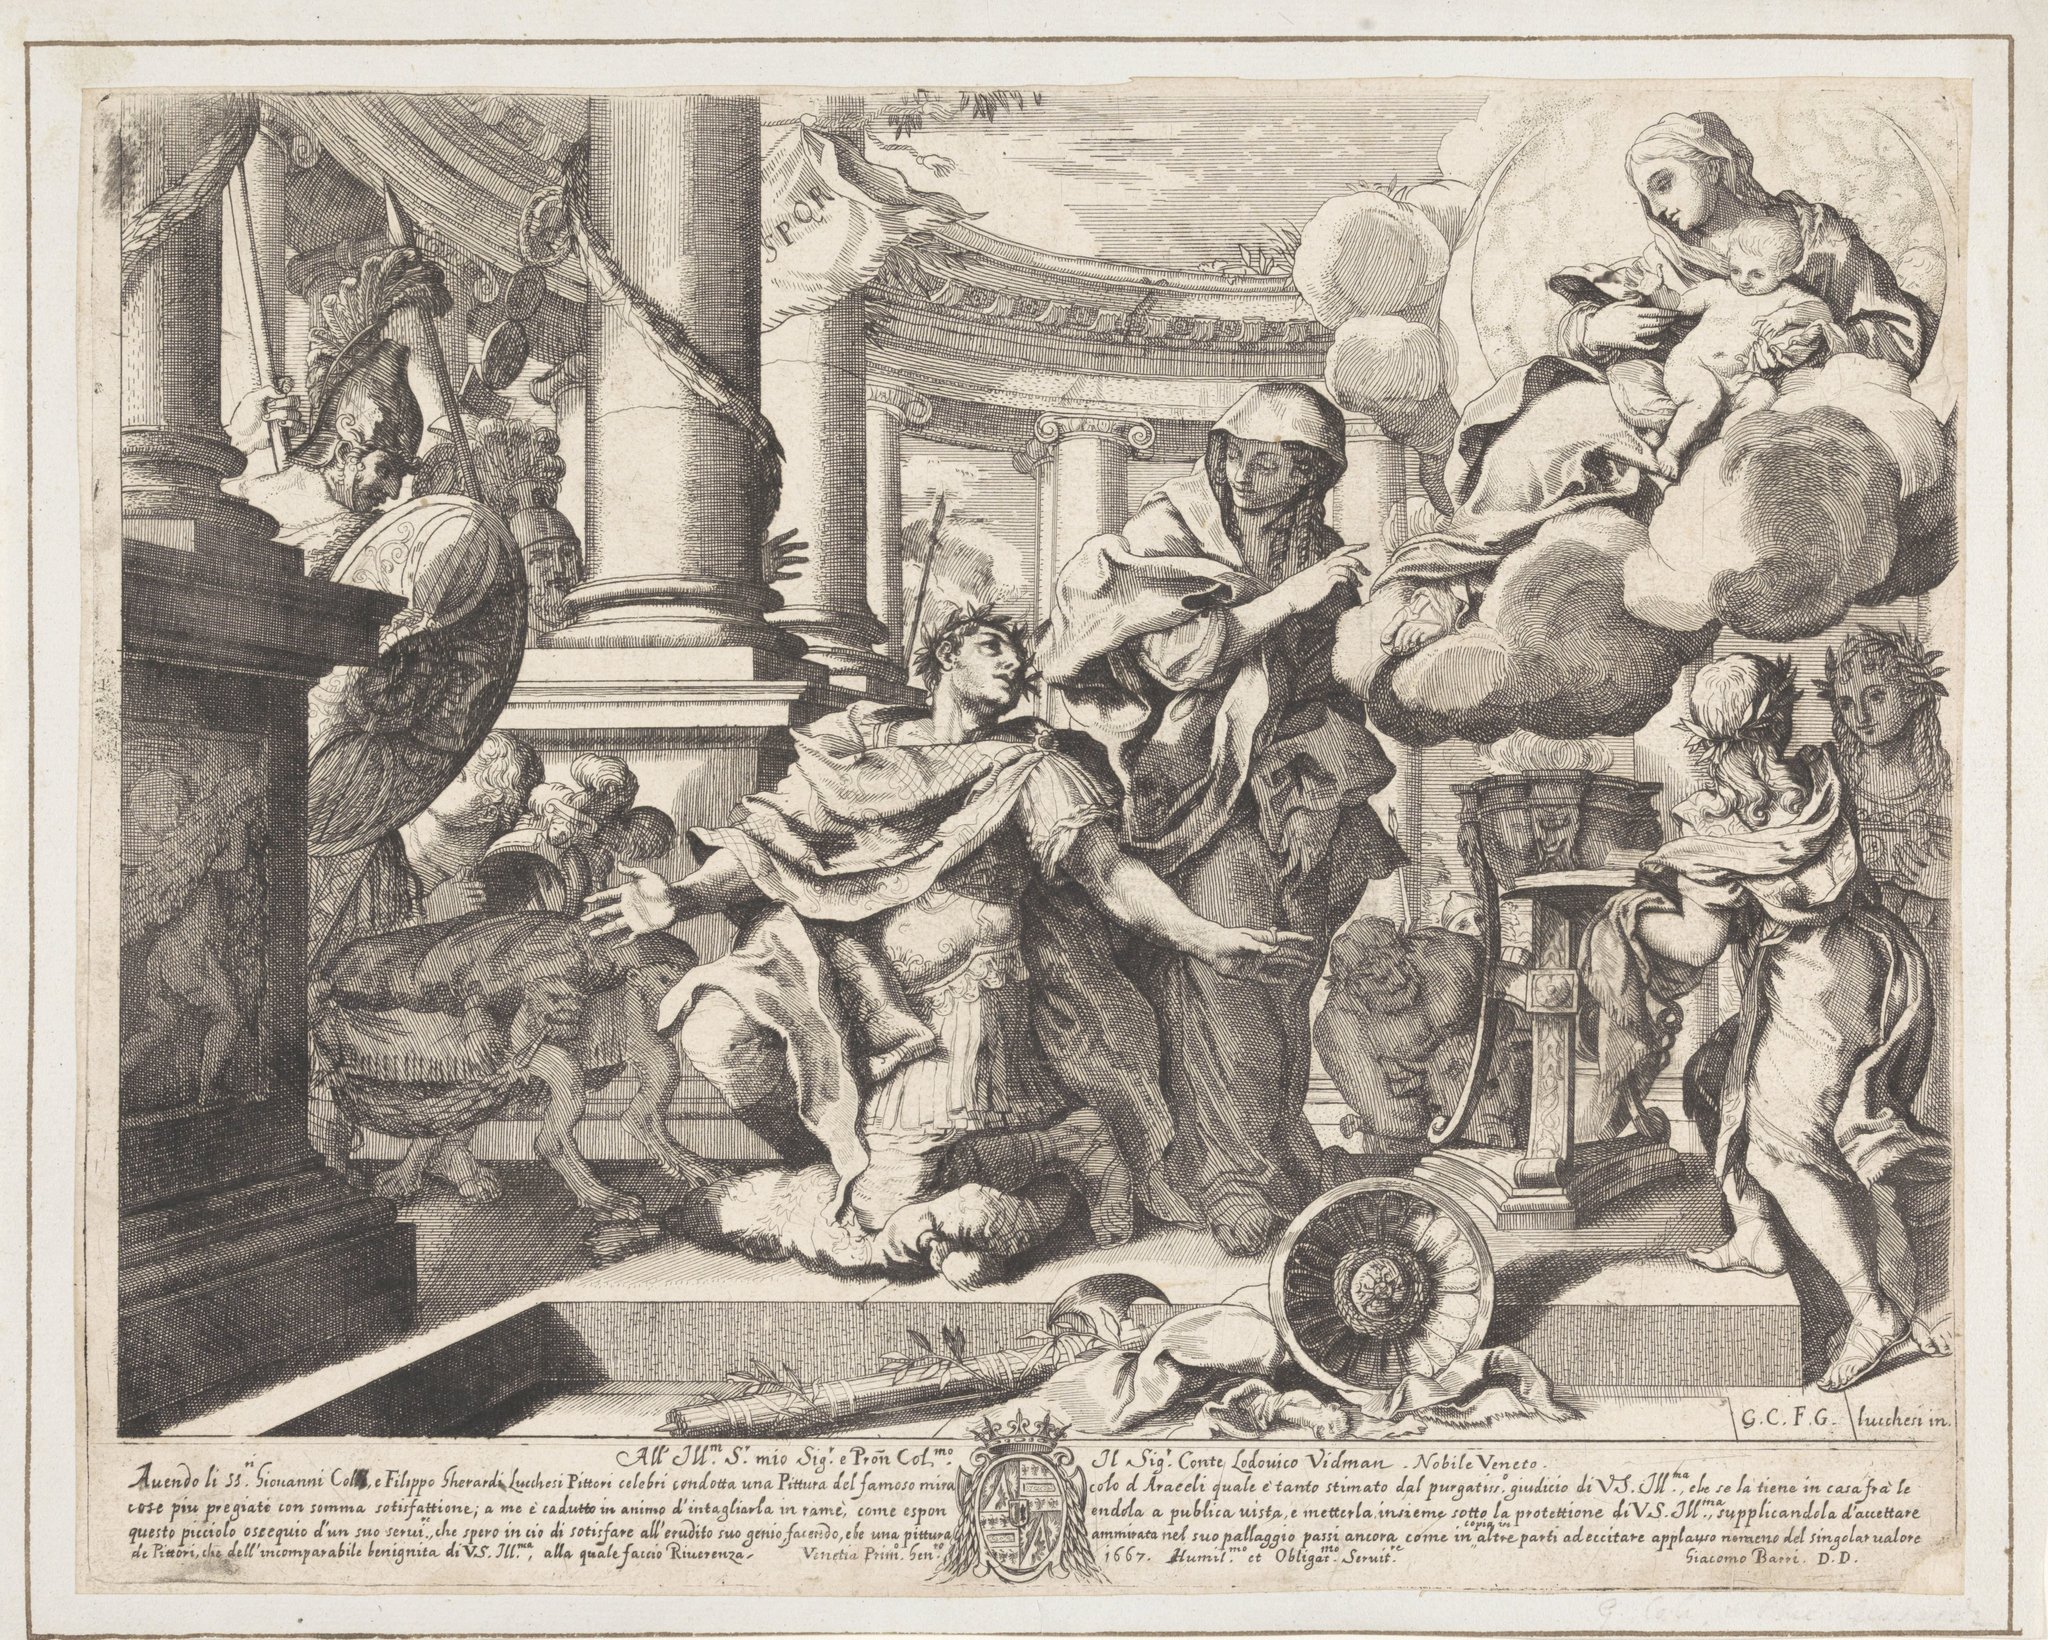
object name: print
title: Keizer Augustus en de Tiburtijnse Sibille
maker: giacomo barri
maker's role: painter, print maker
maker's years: 1630-1690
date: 1667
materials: paper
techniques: etching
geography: italy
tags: the tiburtine sibyl and augustus: the sibyl reveals to the emperor a vision of the madonna in heaven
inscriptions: collector's mark: Lugt 2228, collector's mark: Lugt 2760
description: De Tiburtijnse Sibille toont Keizer Augustus de verschijning van Maria en het Christus kind aan de hemel. Links staan soldaten en rechts bedienden.